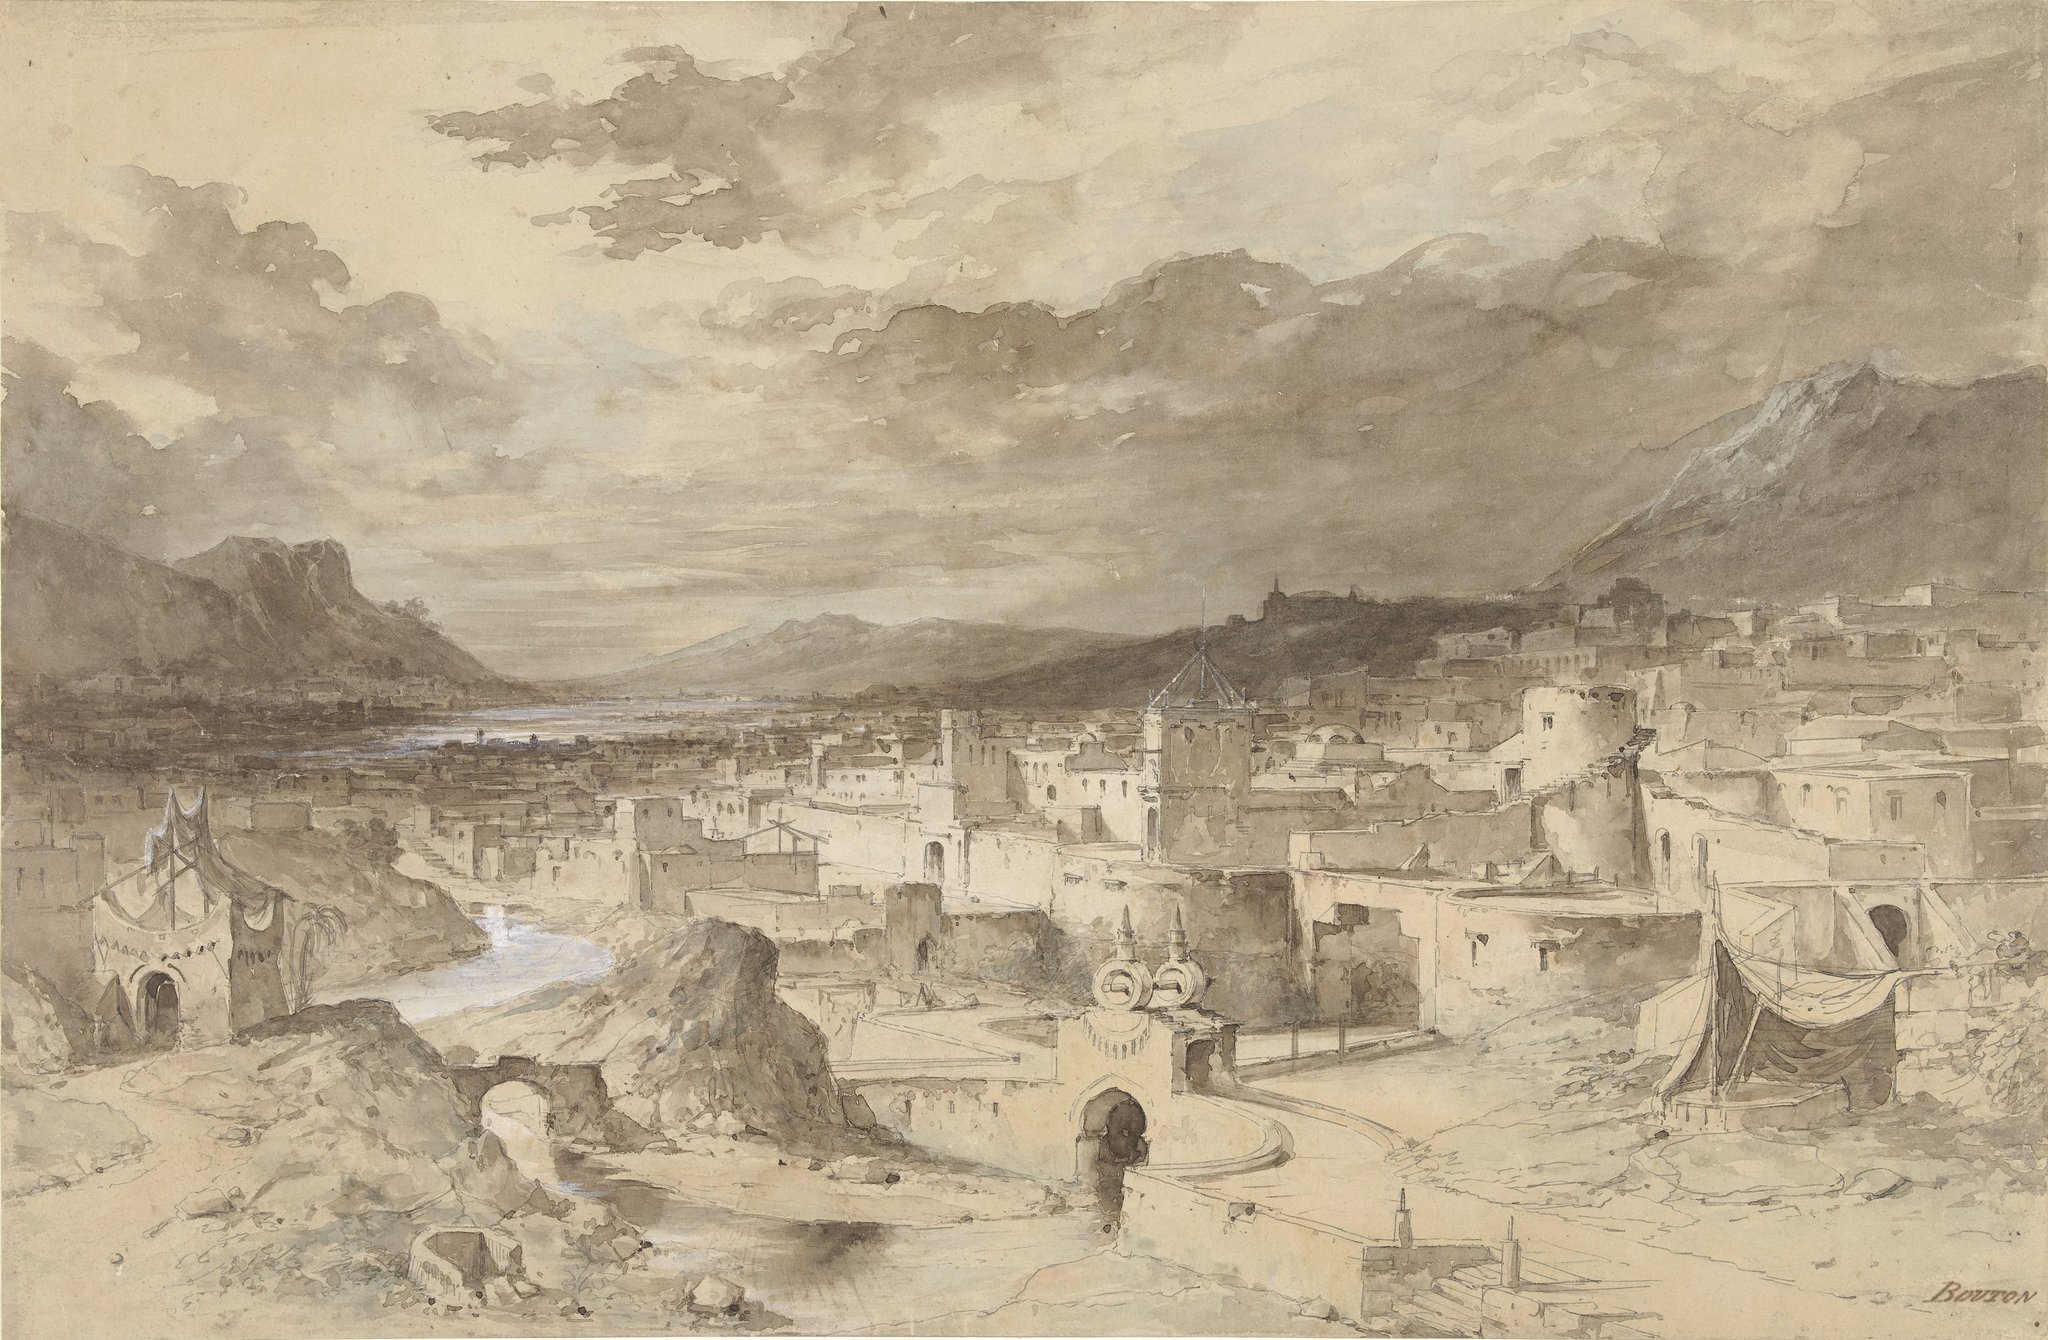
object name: design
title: De stad Enochia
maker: charles marie bouton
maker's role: draughtsman, print maker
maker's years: 1781-1853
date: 1791-1853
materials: ink, paper, pencil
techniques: brush, pen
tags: cain building the city of enoch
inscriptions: inscription: ‘La ville d'Enochia’